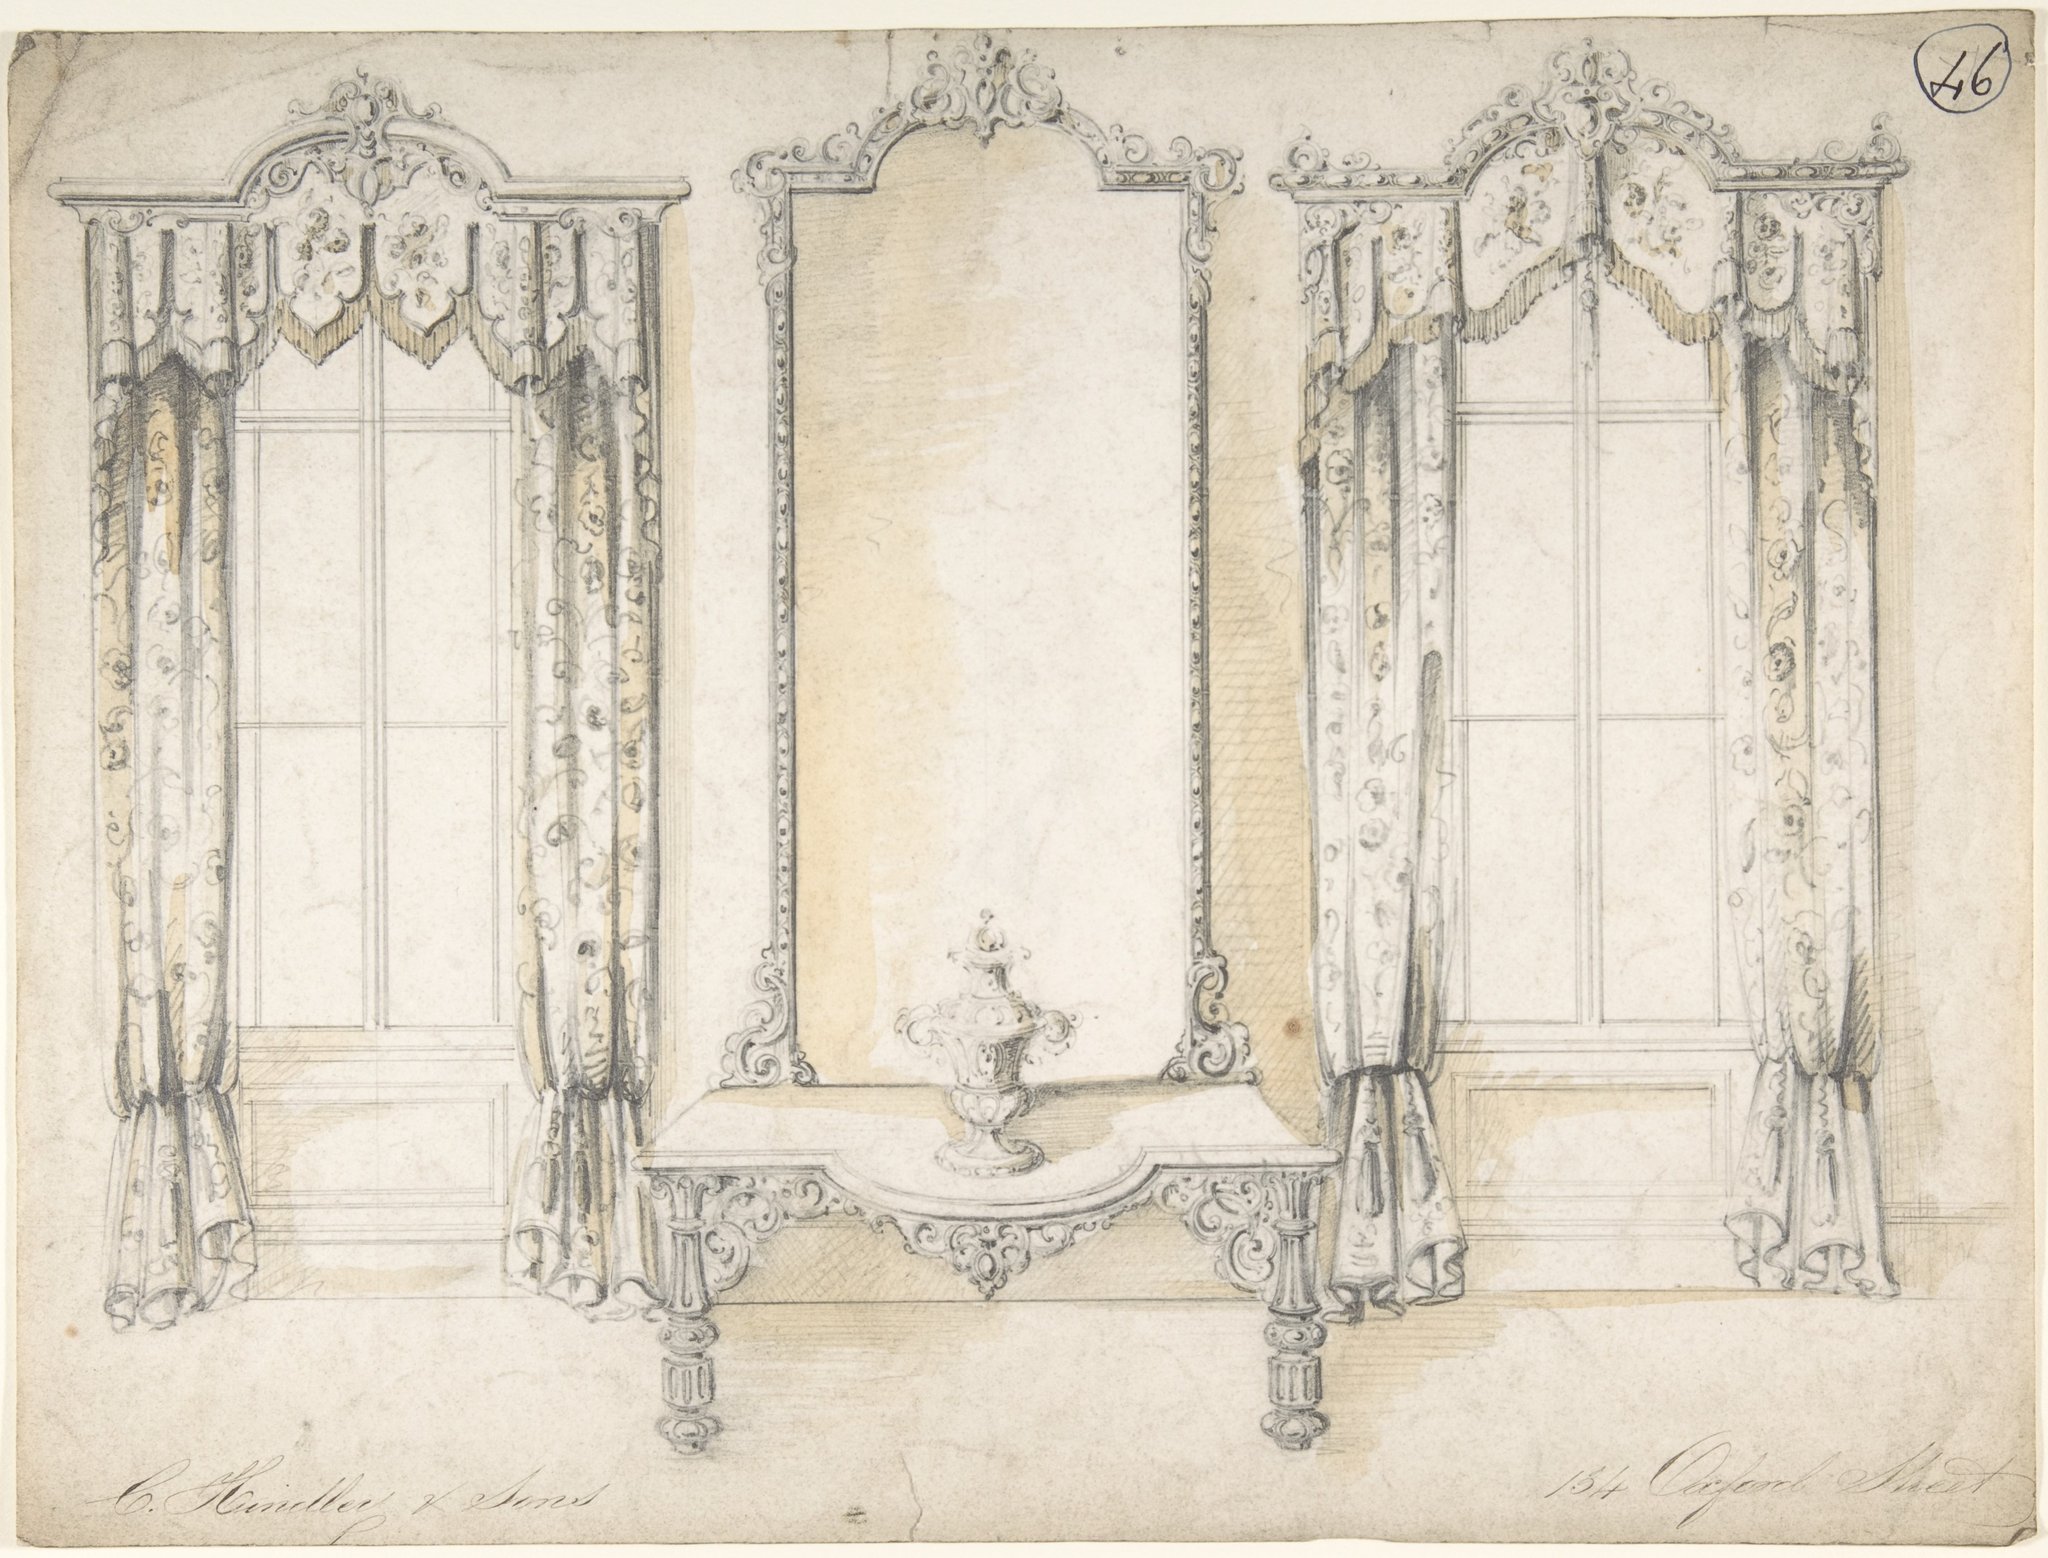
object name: drawing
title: Design for Wall with Fireplace and Side Tables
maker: charles hindley and sons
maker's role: artist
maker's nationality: british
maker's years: 1841-1917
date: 1841-1884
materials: gouache, graphite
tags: tables,mirrors